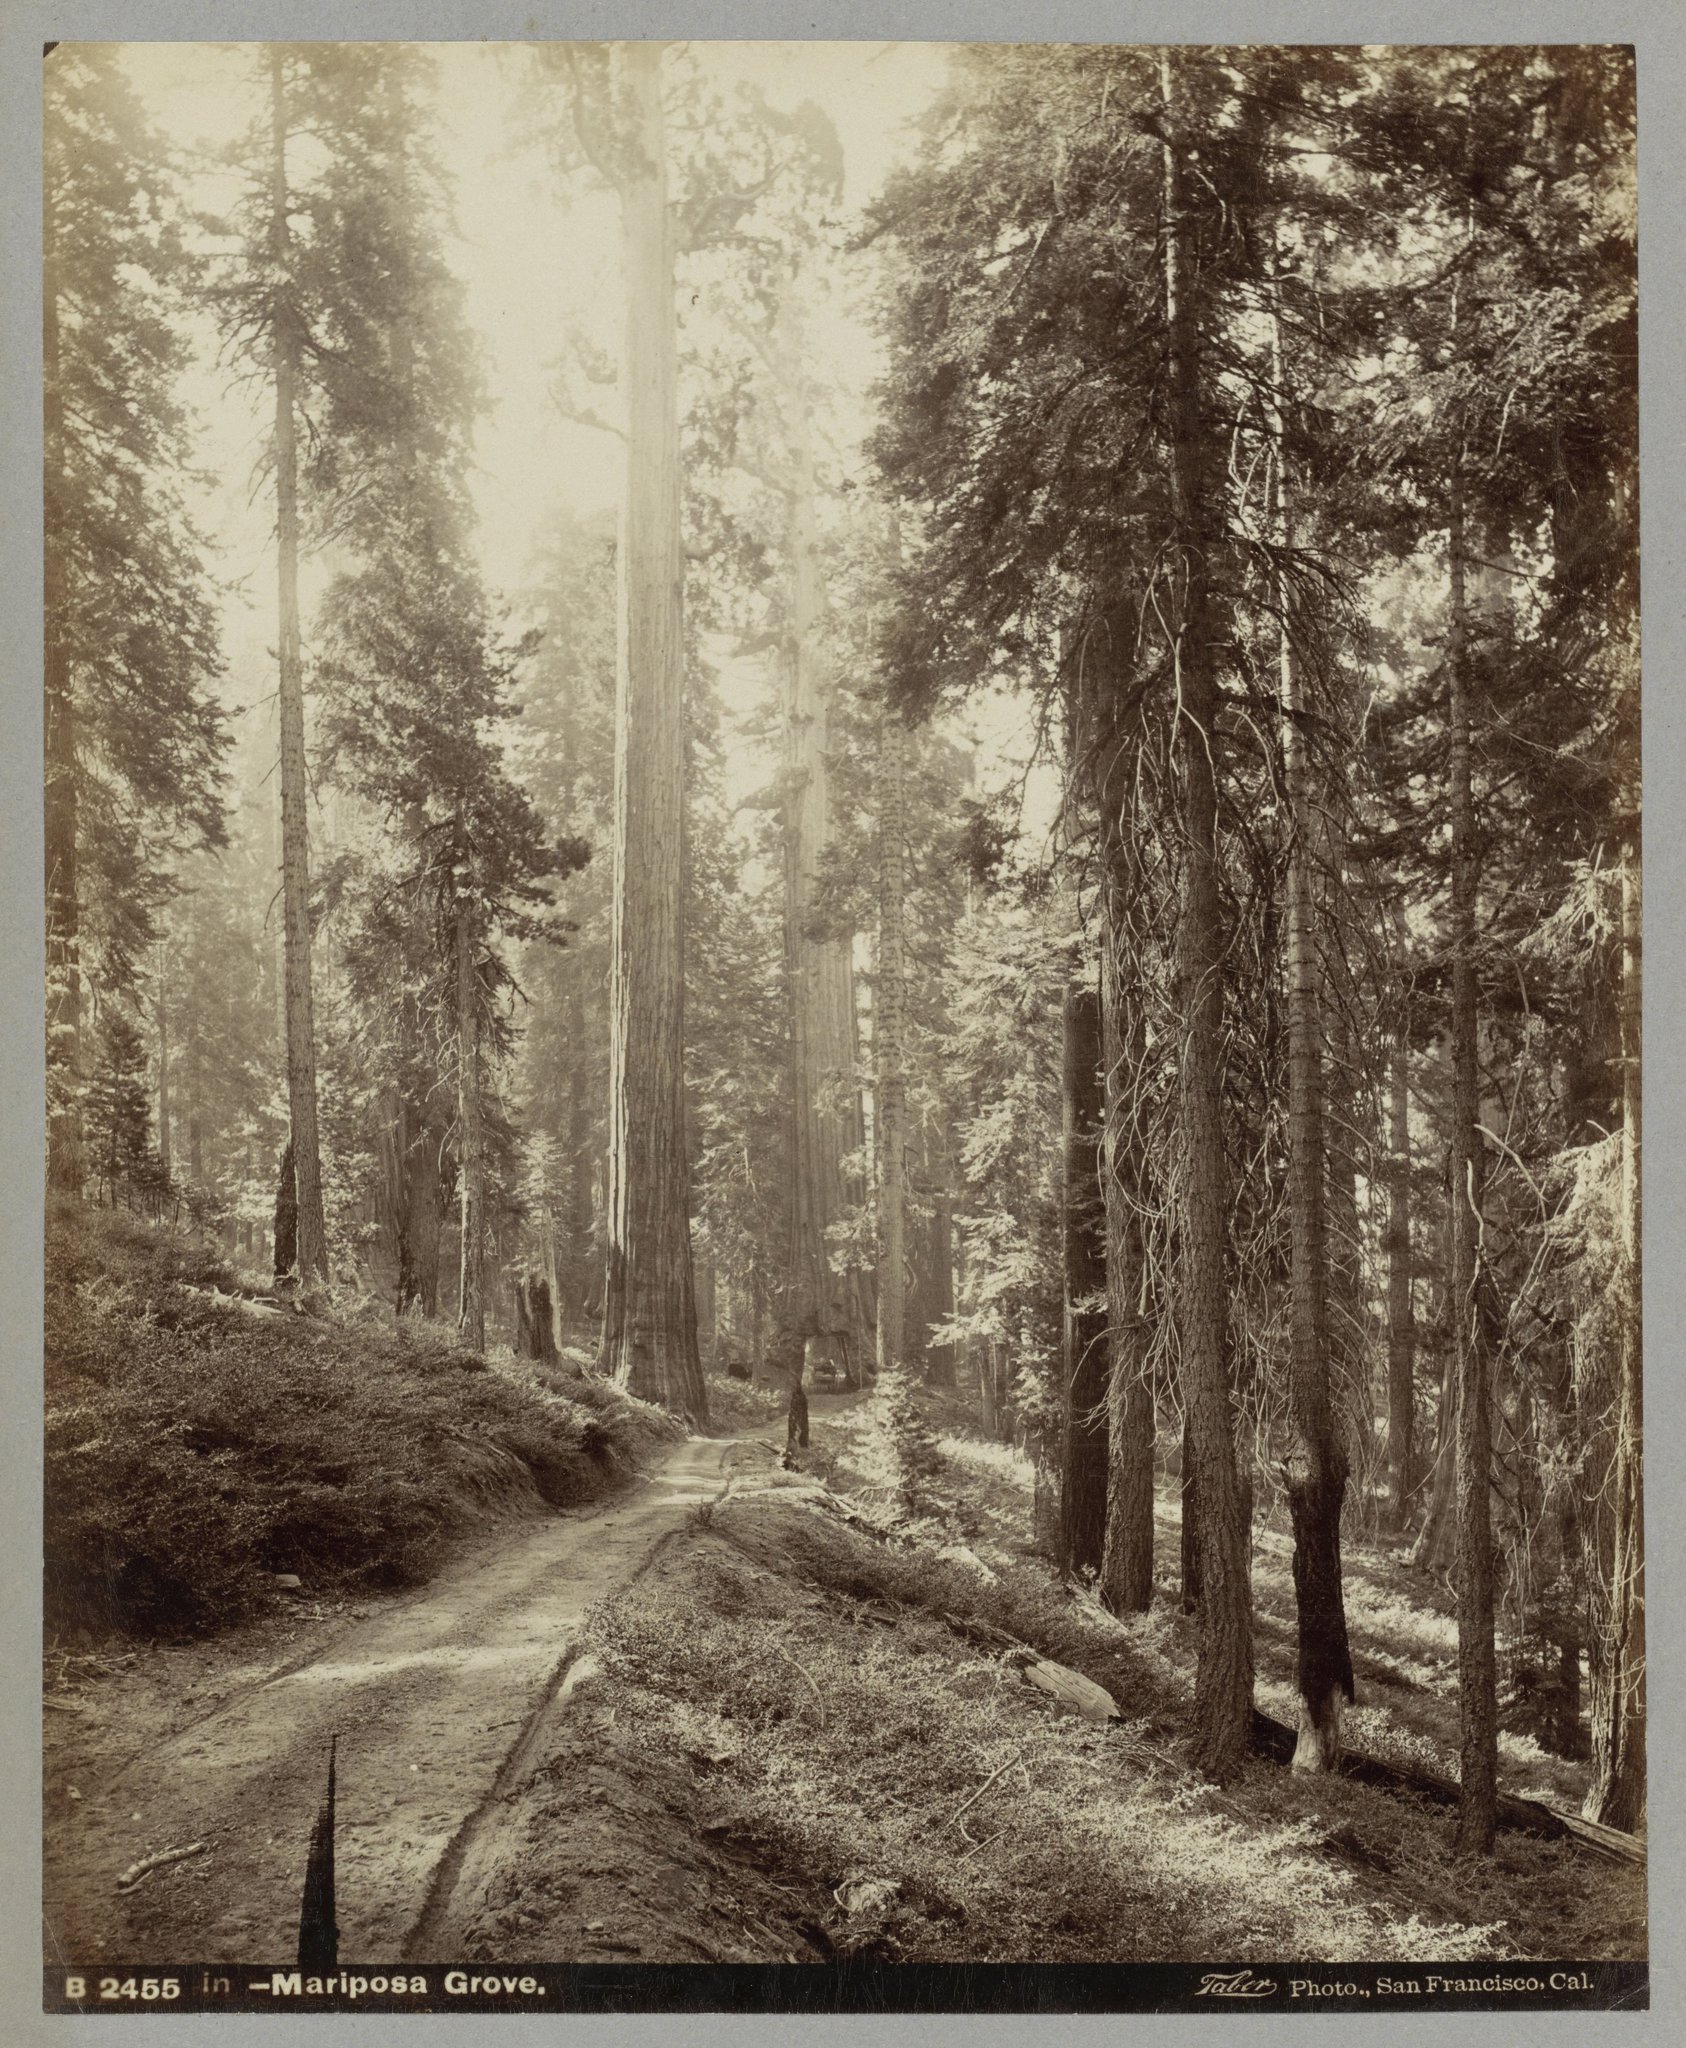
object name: photograph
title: Mariposa Grove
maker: isaiah west taber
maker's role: fotograaf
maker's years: 1830-1912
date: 1880-1900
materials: cardboard, paper, photographic support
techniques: albumen print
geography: yosemite national park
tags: trees: sequoia, road, path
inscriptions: negative number: ‘B 2455’